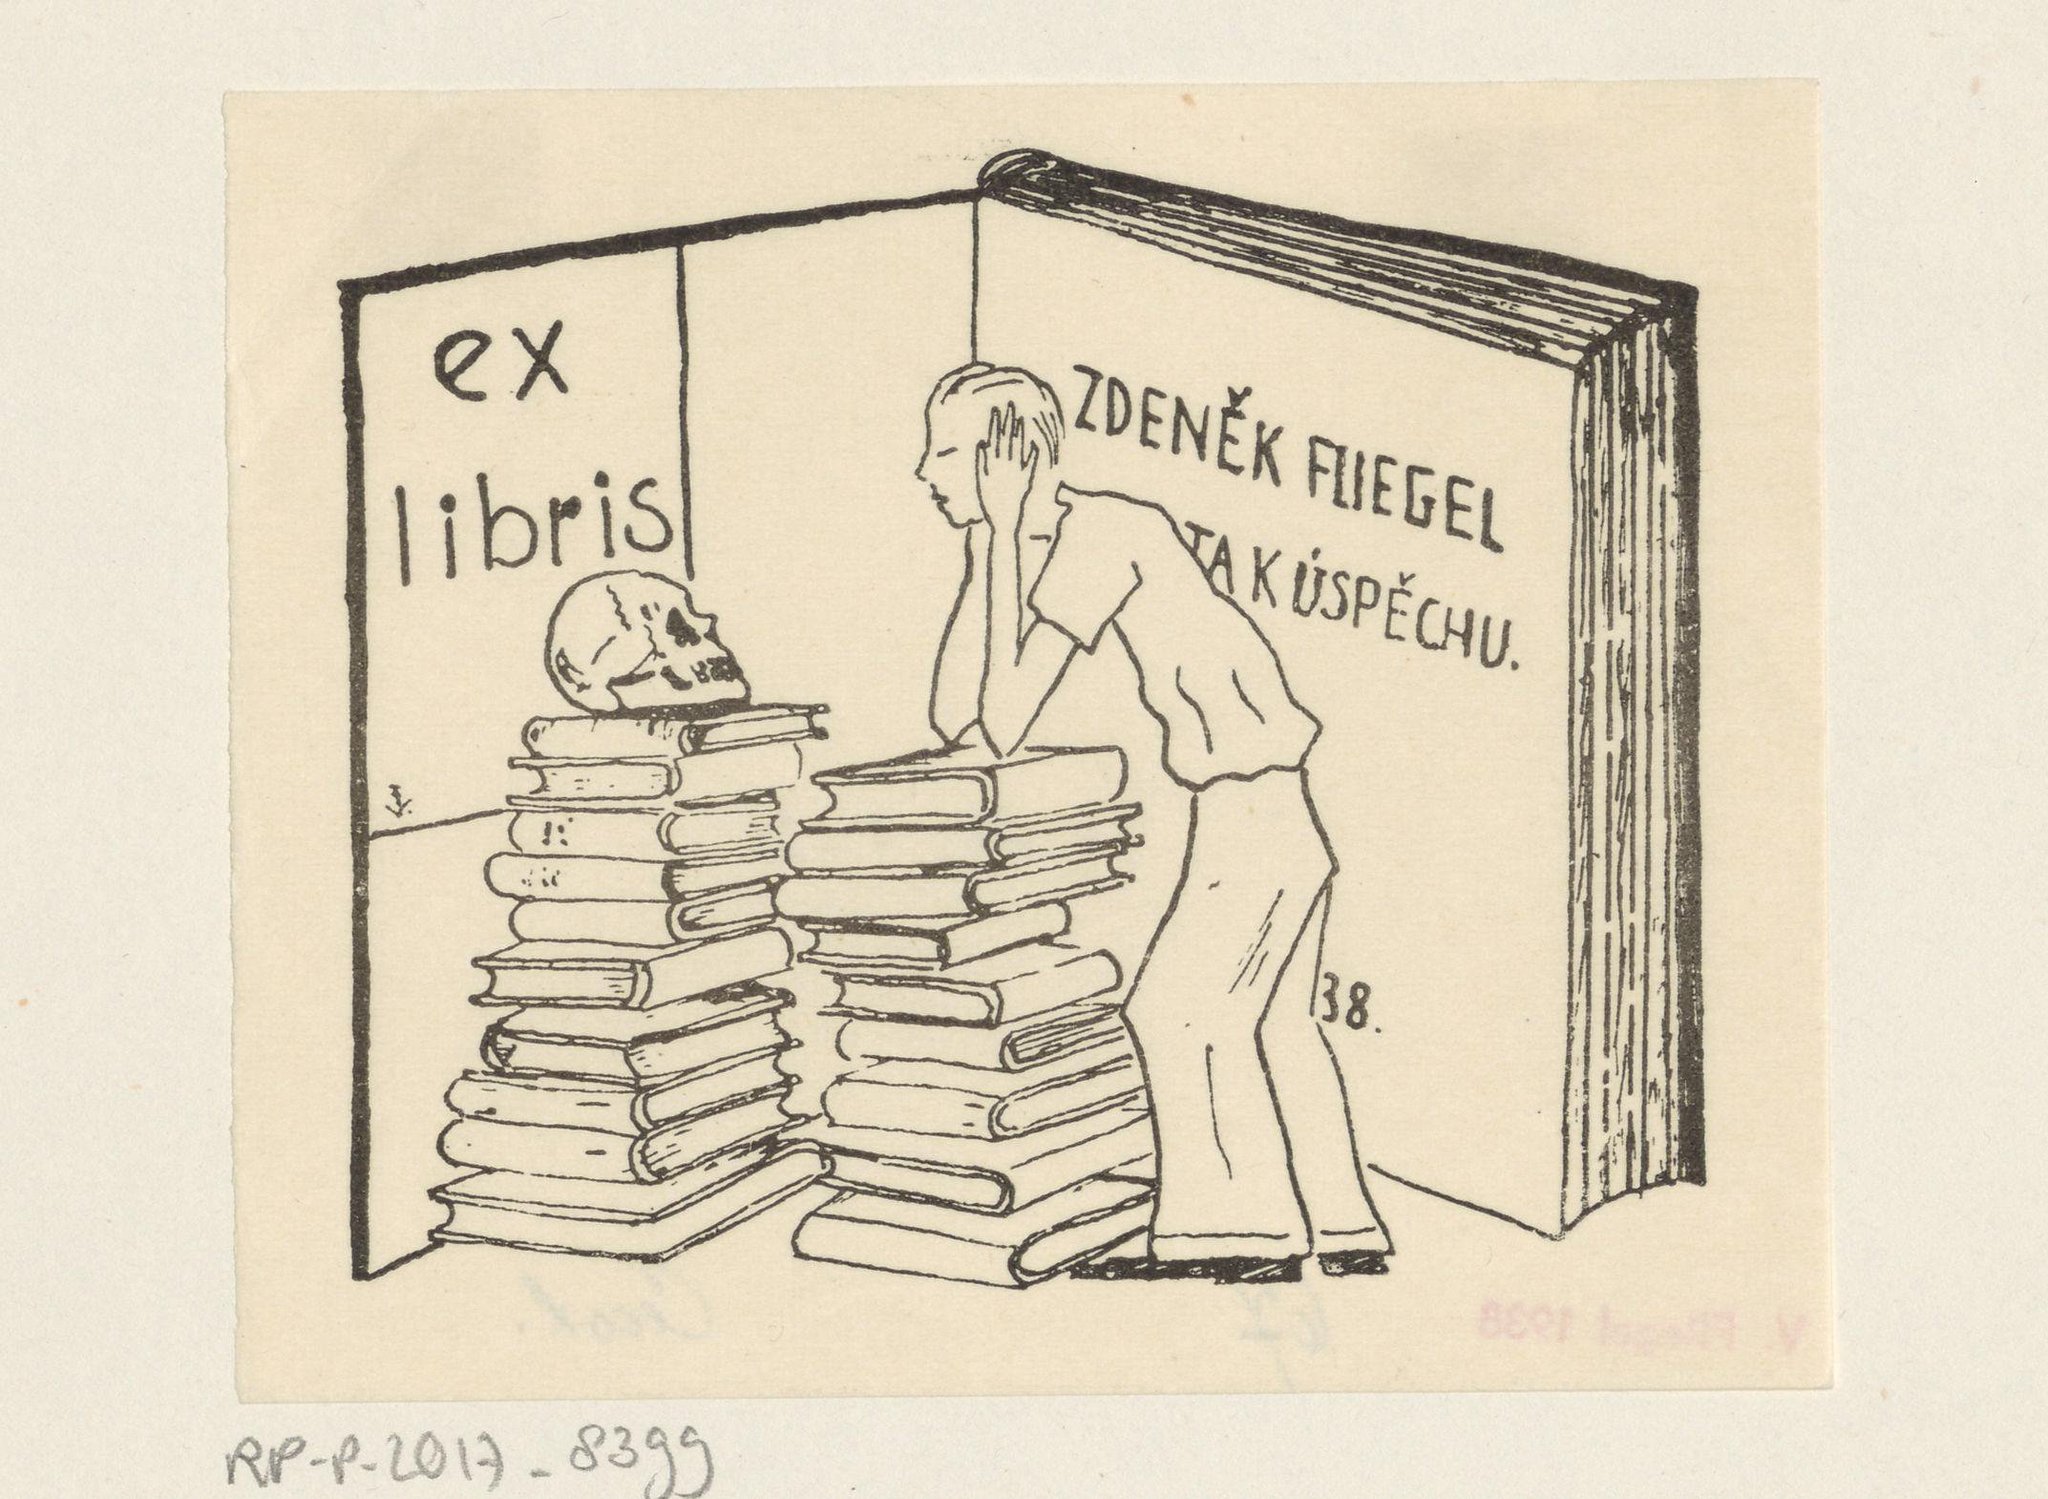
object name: bookplate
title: Ex libris van Zdeněk Fliegel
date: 1938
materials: paper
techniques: printing block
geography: czech republic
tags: zdeněk fliegel, standing figure, (human) skull, book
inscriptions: workshop stamp: ‘V. Fliegel 1938’